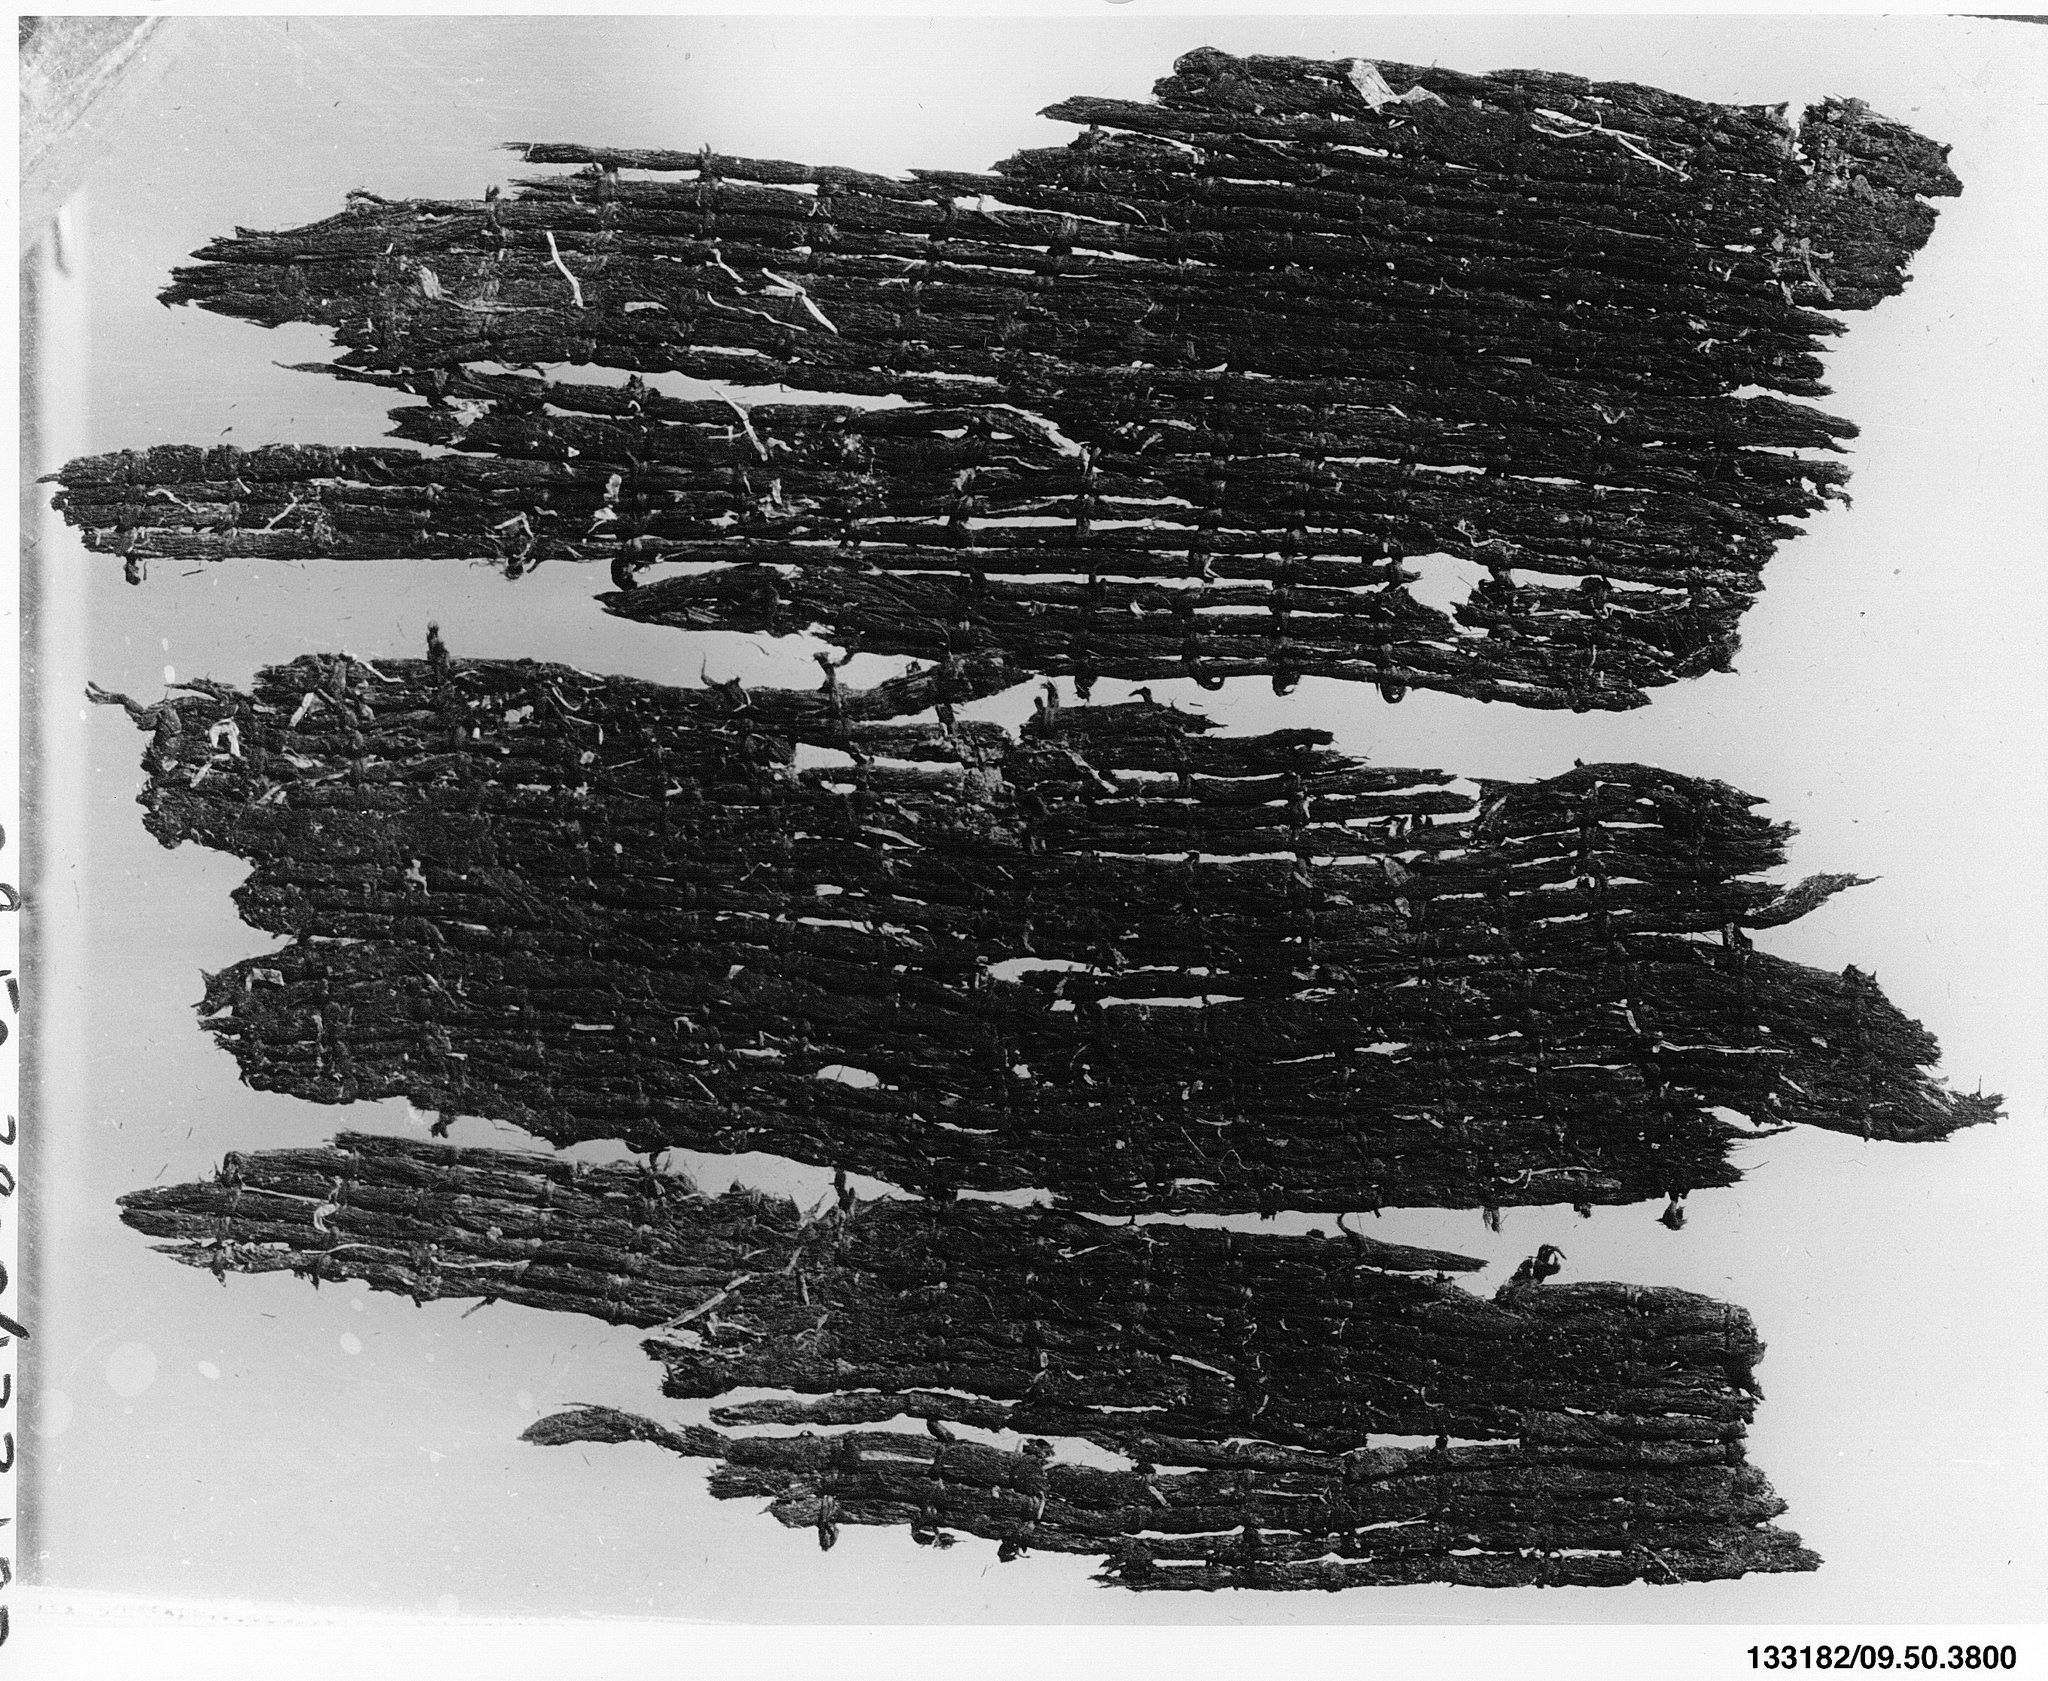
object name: fragment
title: Textile Fragment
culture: swiss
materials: textile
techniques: weave